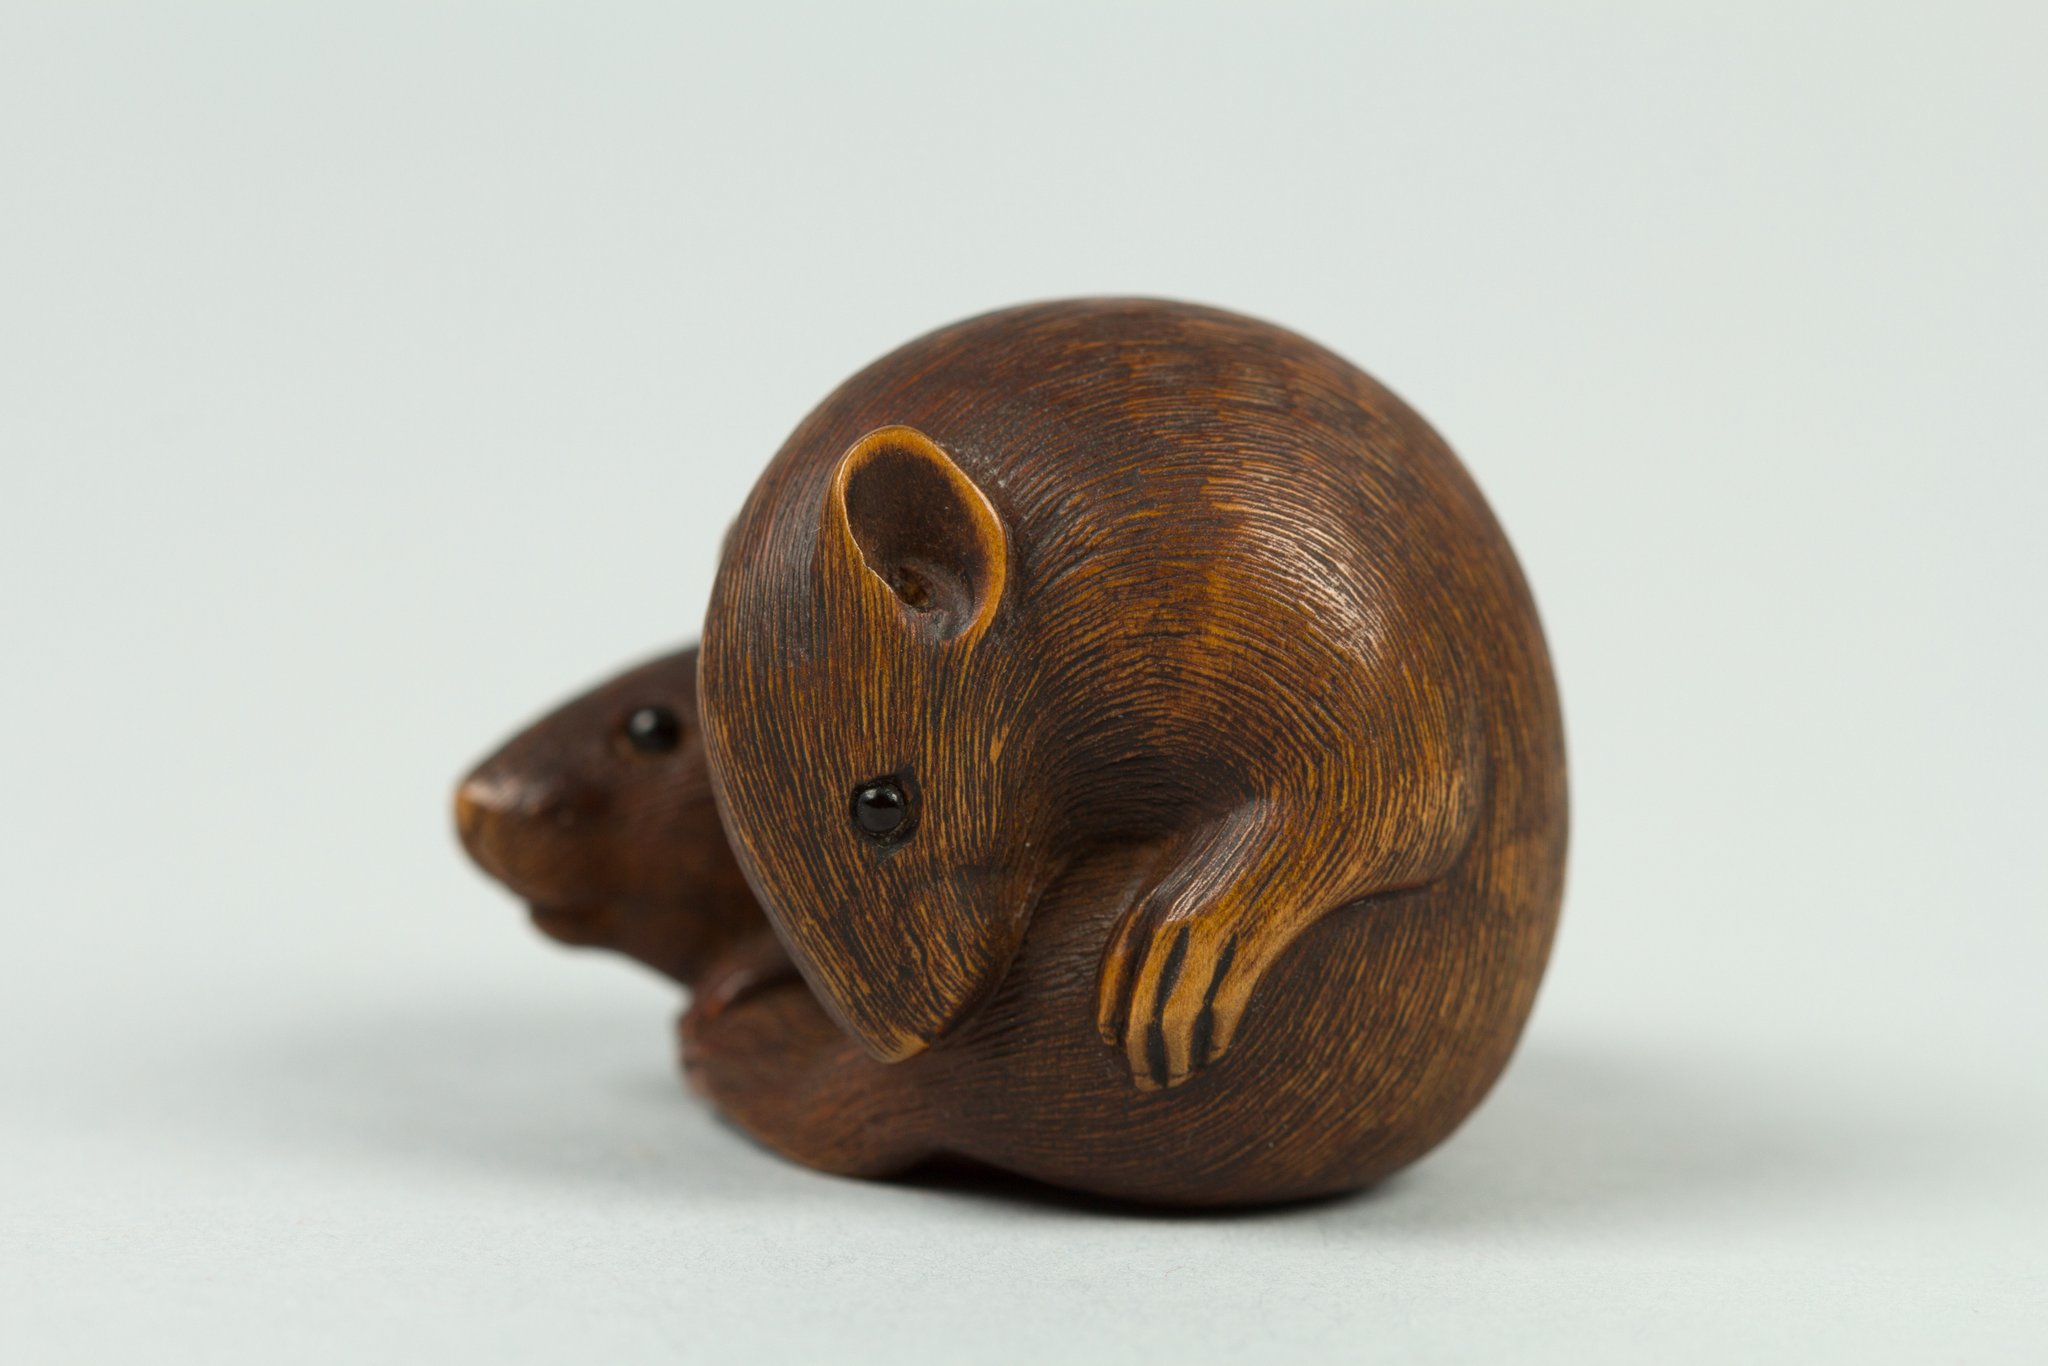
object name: netsuke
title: Netsuke of Two Rats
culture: japanese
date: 1851-1900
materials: wood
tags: mice,rats